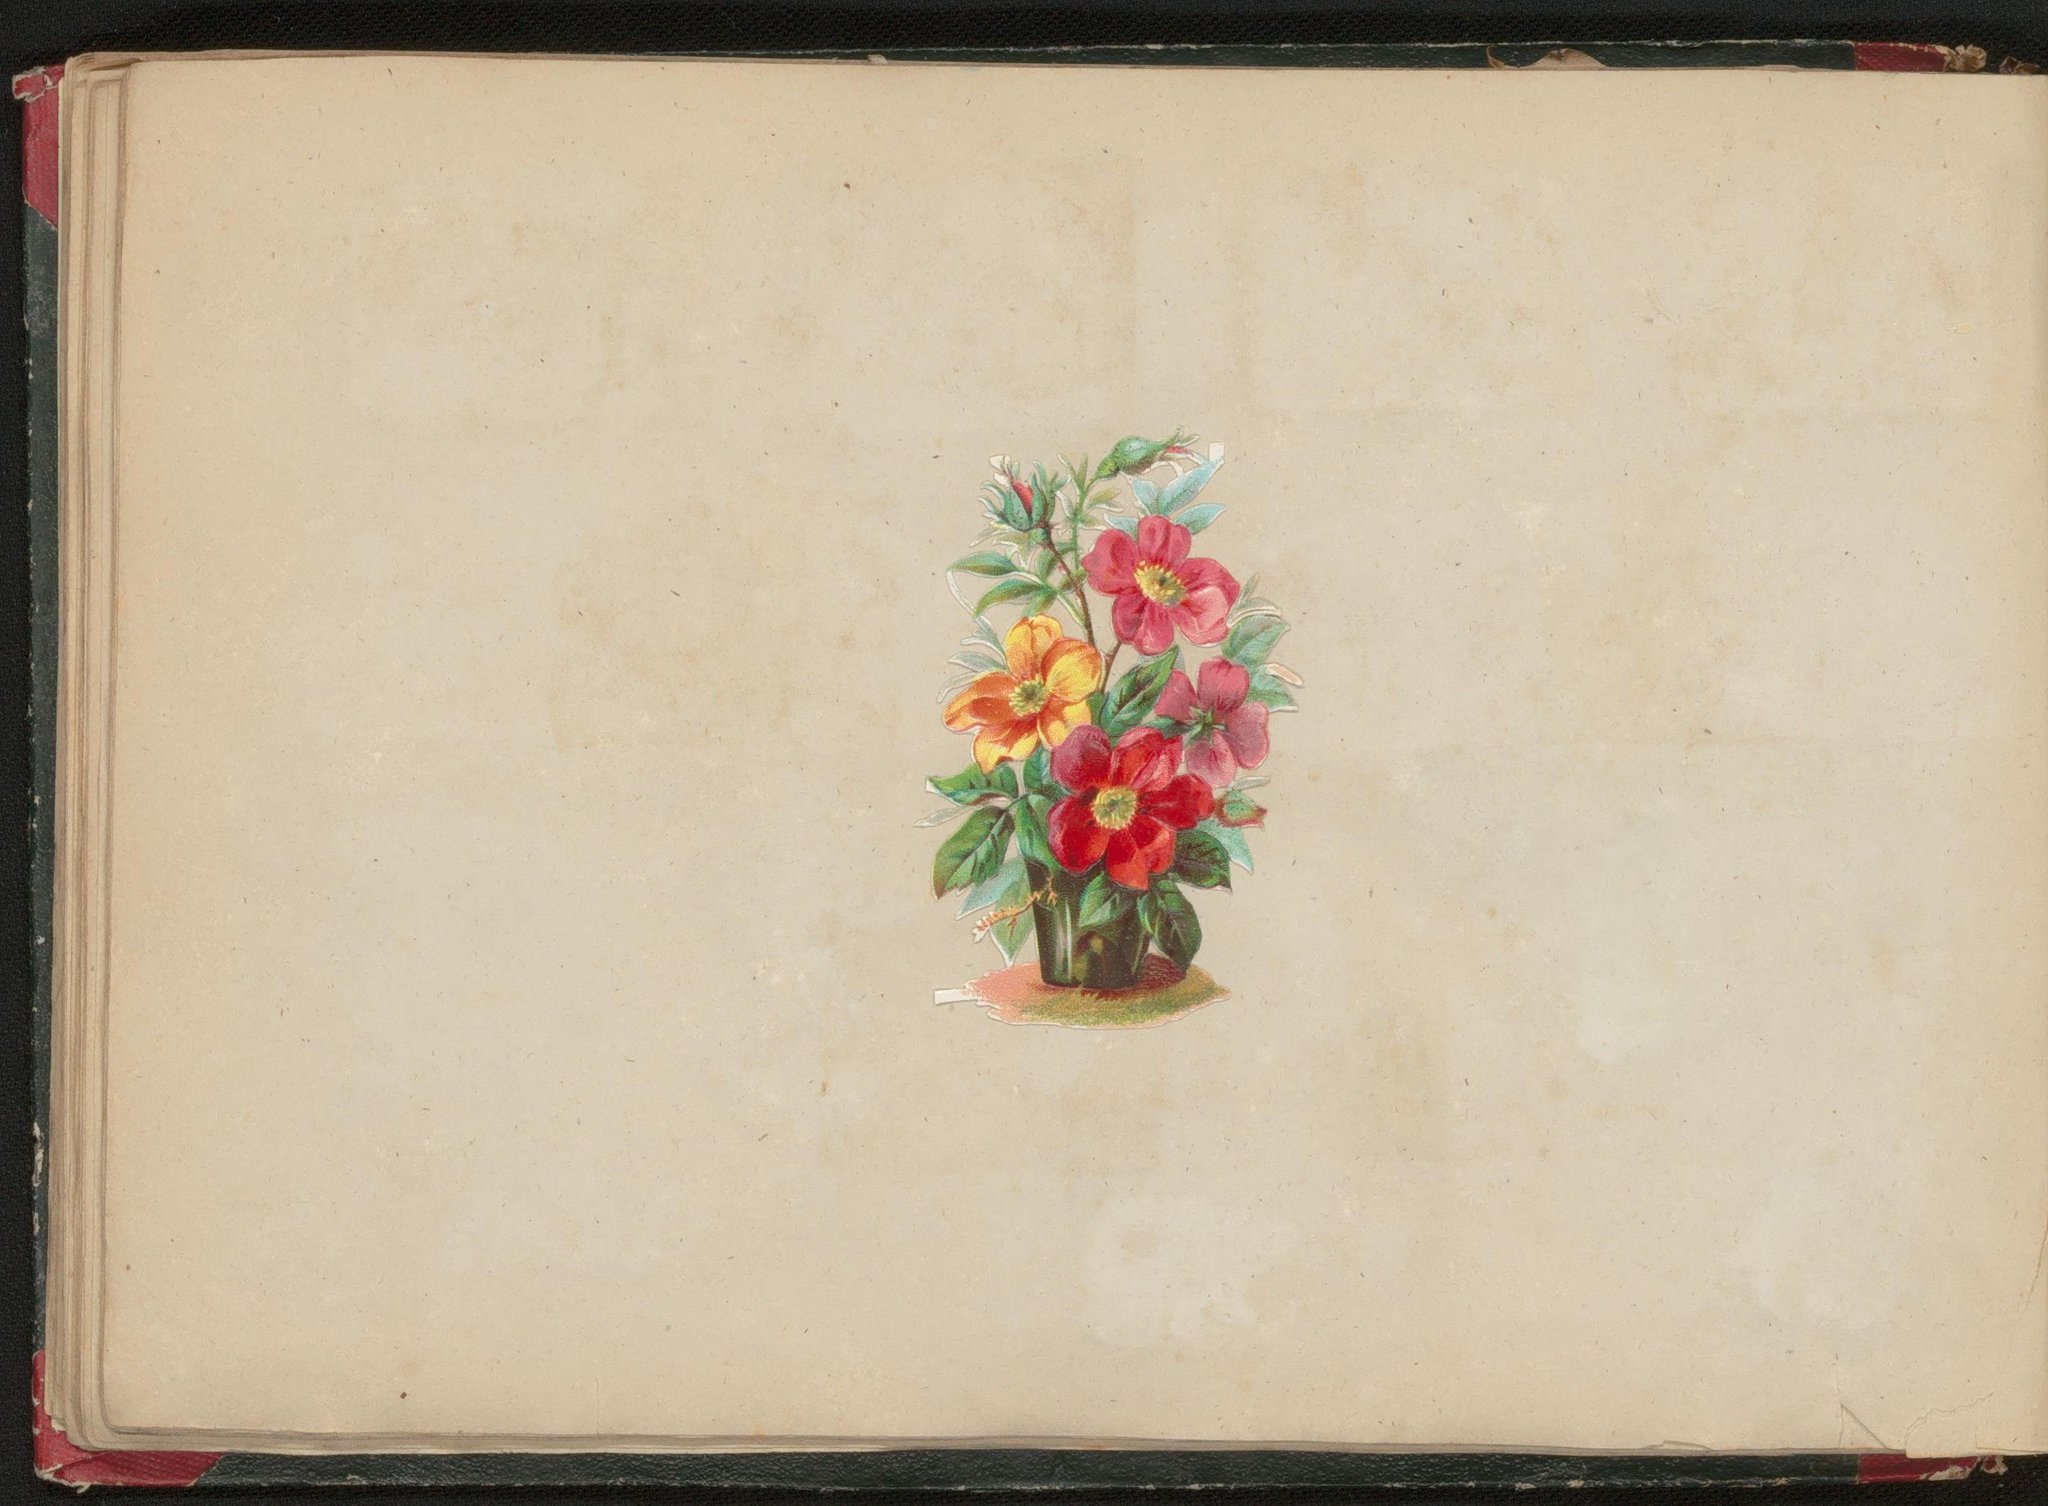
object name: album leaf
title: Albumblad met 1 plakplaatje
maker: Anonymous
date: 1880-1910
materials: paper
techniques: chromolithography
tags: flowers in a vase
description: Albumblad met 1 plakplaatje van een vaas met bloemen. Onderdeel van het plakboek met 38 bladen gevuld met plakplaatjes, poesieplaatjes en uitgeknipte en ingeplakte fragmenten van prenten. Onderwerpsrubrieken binnen de Atlas Zeden en Gewoonten: Schoone kunsten, Varia.